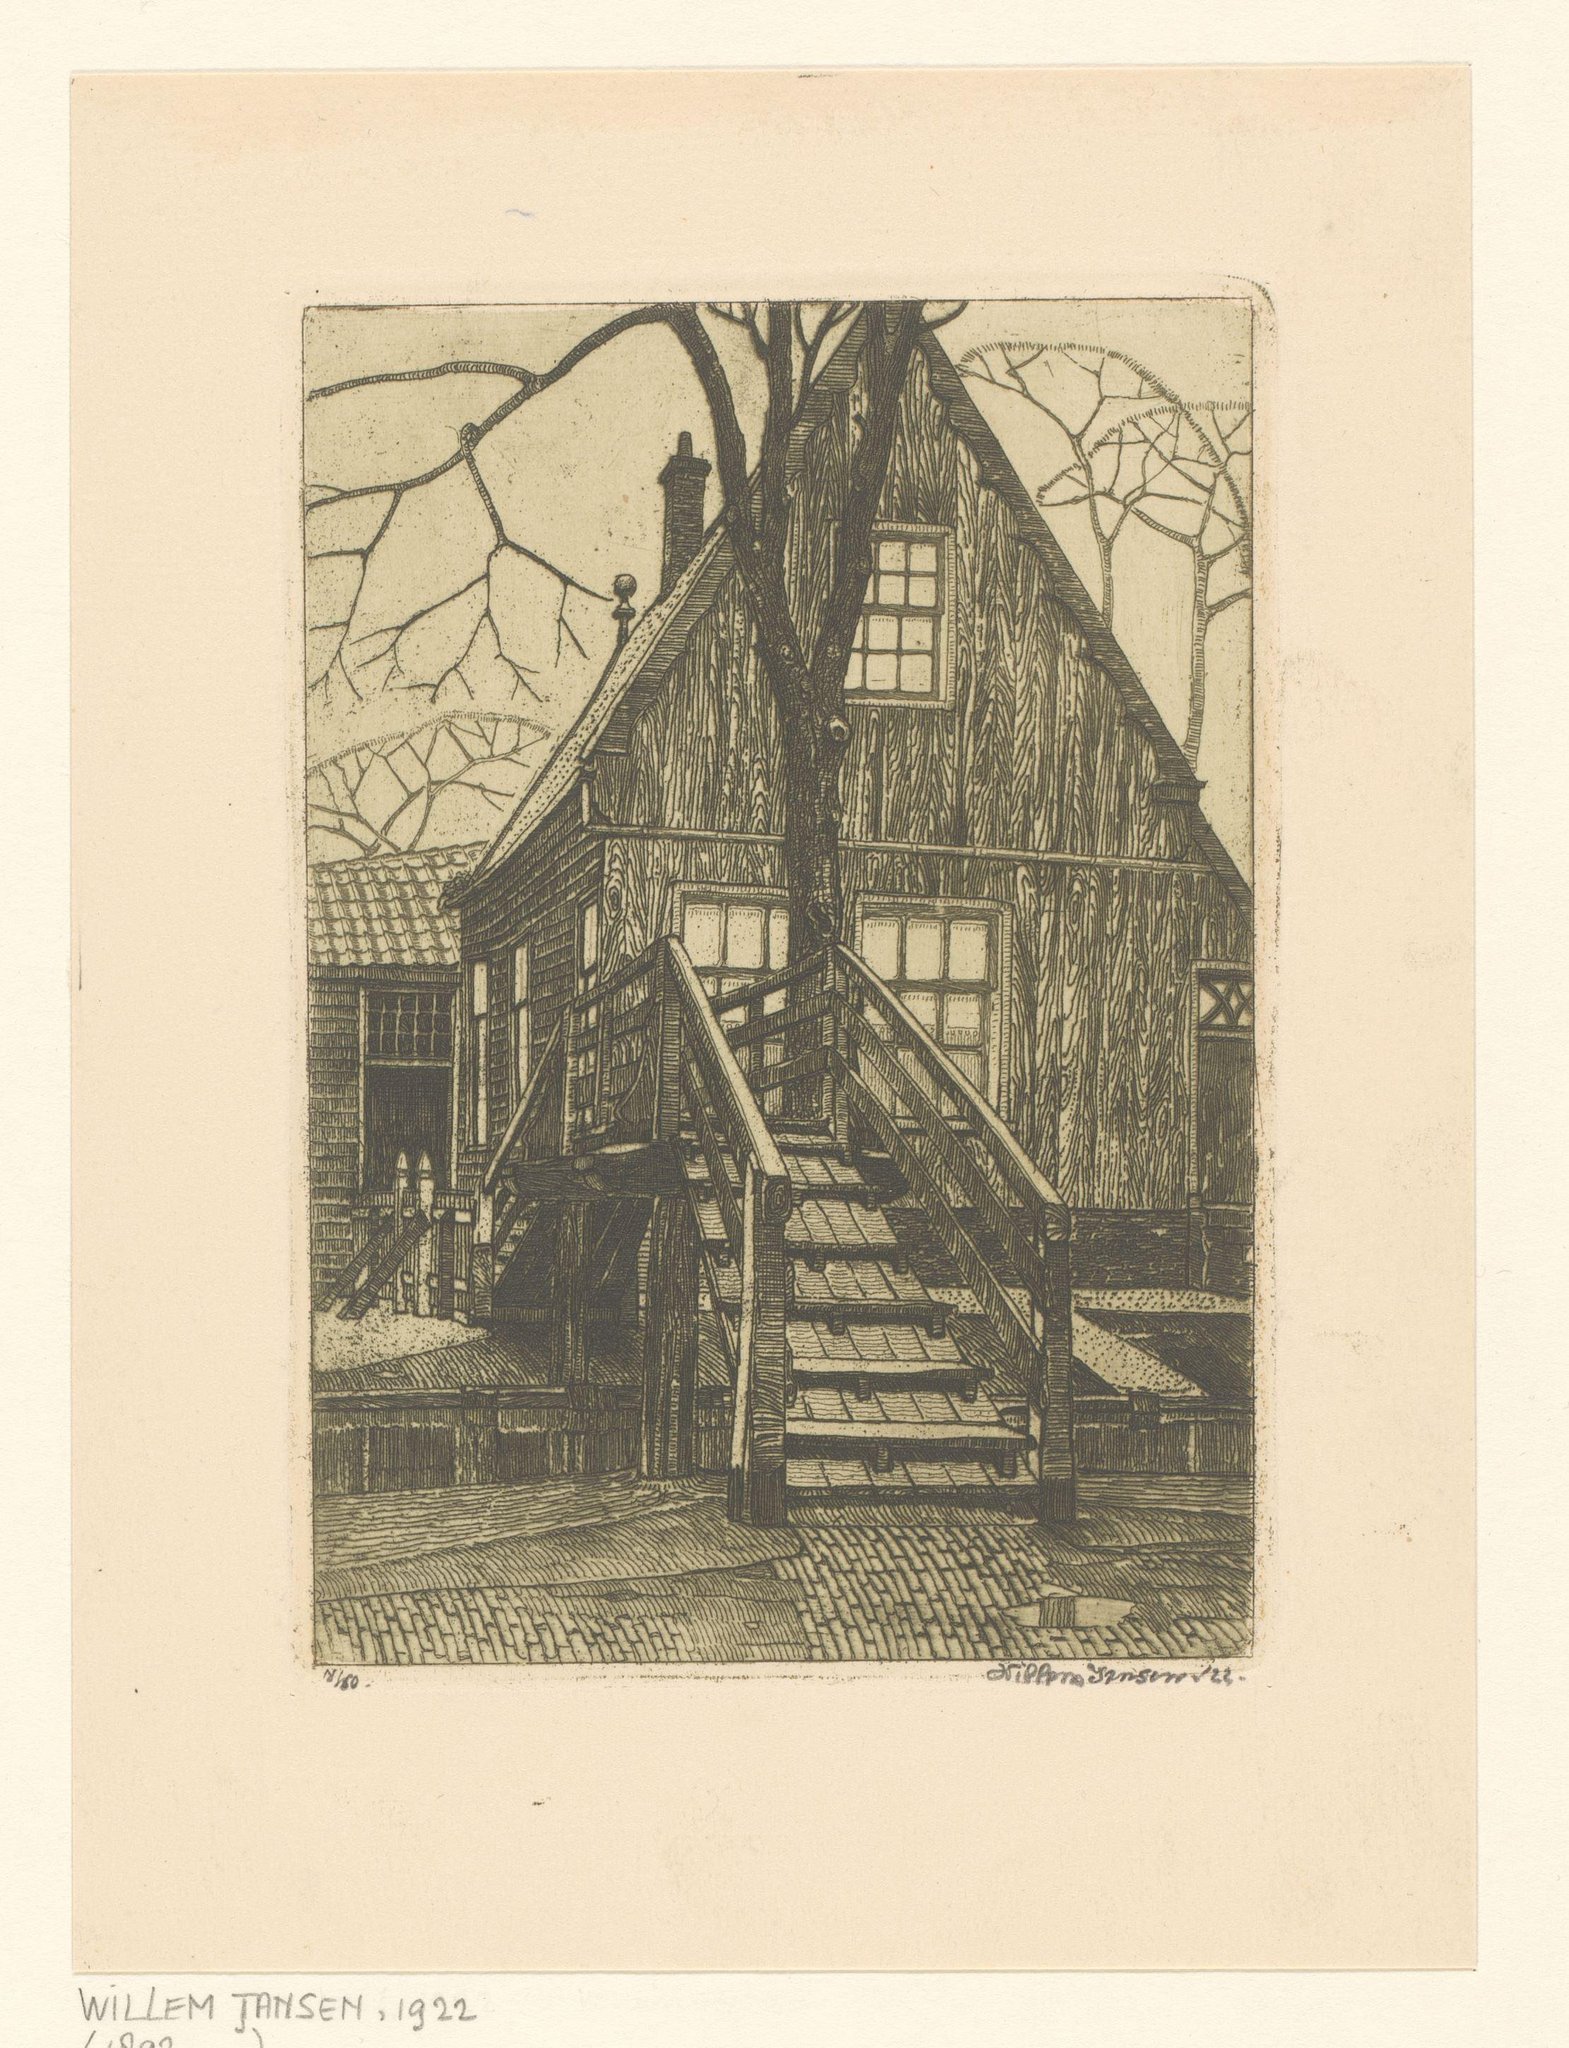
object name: print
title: Huis met brug te Westzaan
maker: willem jansen (graveur)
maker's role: print maker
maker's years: 1892-1969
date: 1922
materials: paper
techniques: etching, intaglio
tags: housing, bridge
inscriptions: signature: ‘Willem Jansen /22’, inscription: ‘Willem Jansen aanw 1924’, collector's mark: Lugt 2228, collector's mark: Lugt 2760